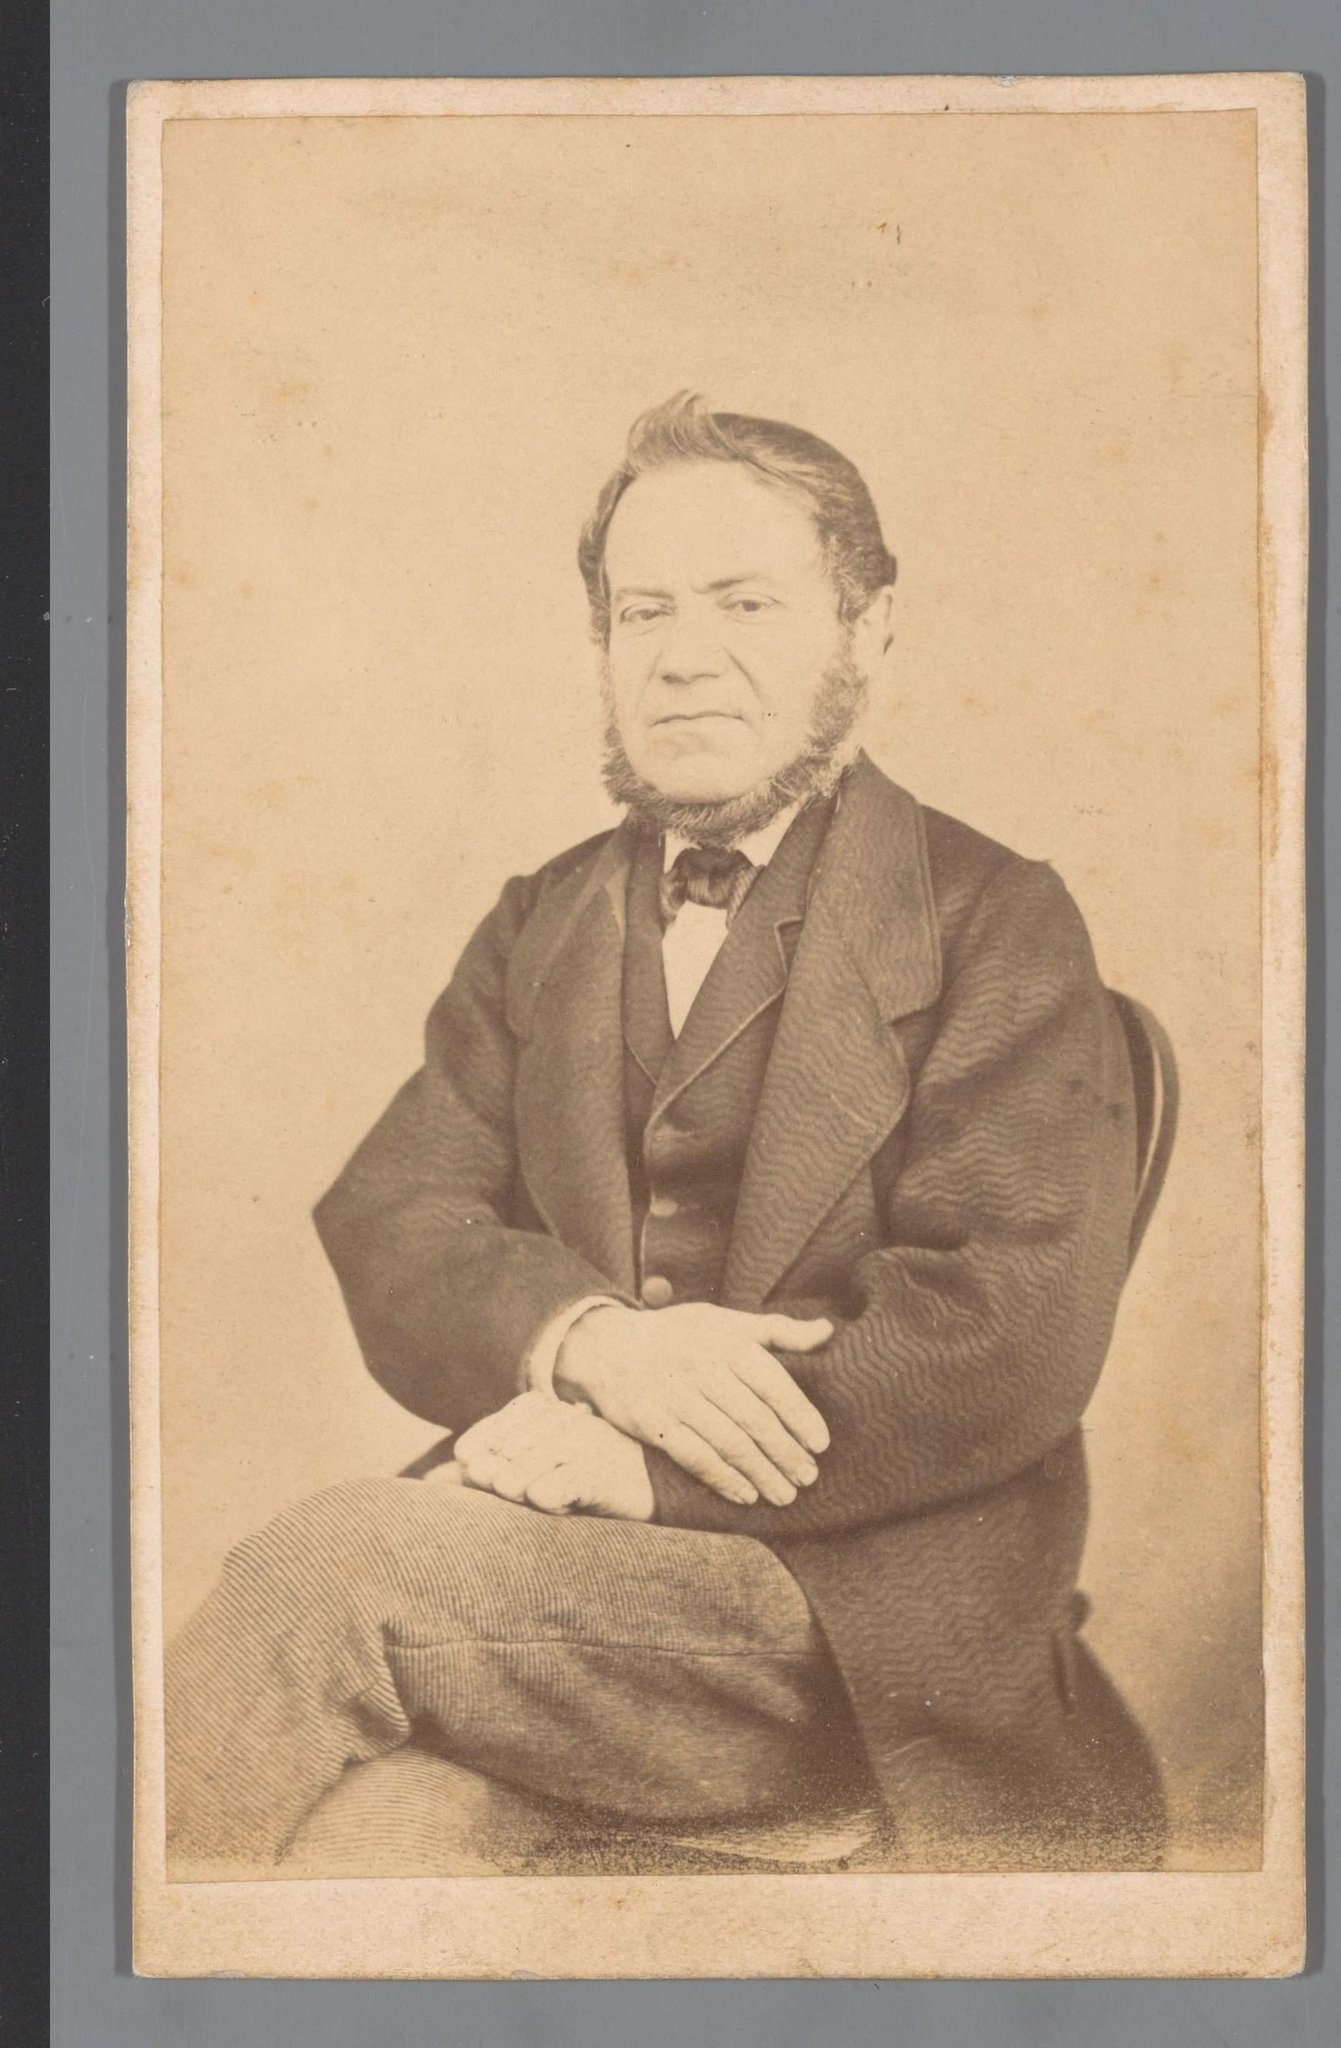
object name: photograph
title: Portret van een man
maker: Anonymous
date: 1850-1899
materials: cardboard, paper, photographic support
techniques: albumen print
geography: netherlands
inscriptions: annotation: ‘Señor Malerdo’, address: ‘M.M.E.’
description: Zittende man met ringbaard en kuifje. Kniestuk, zonder achtergrond.